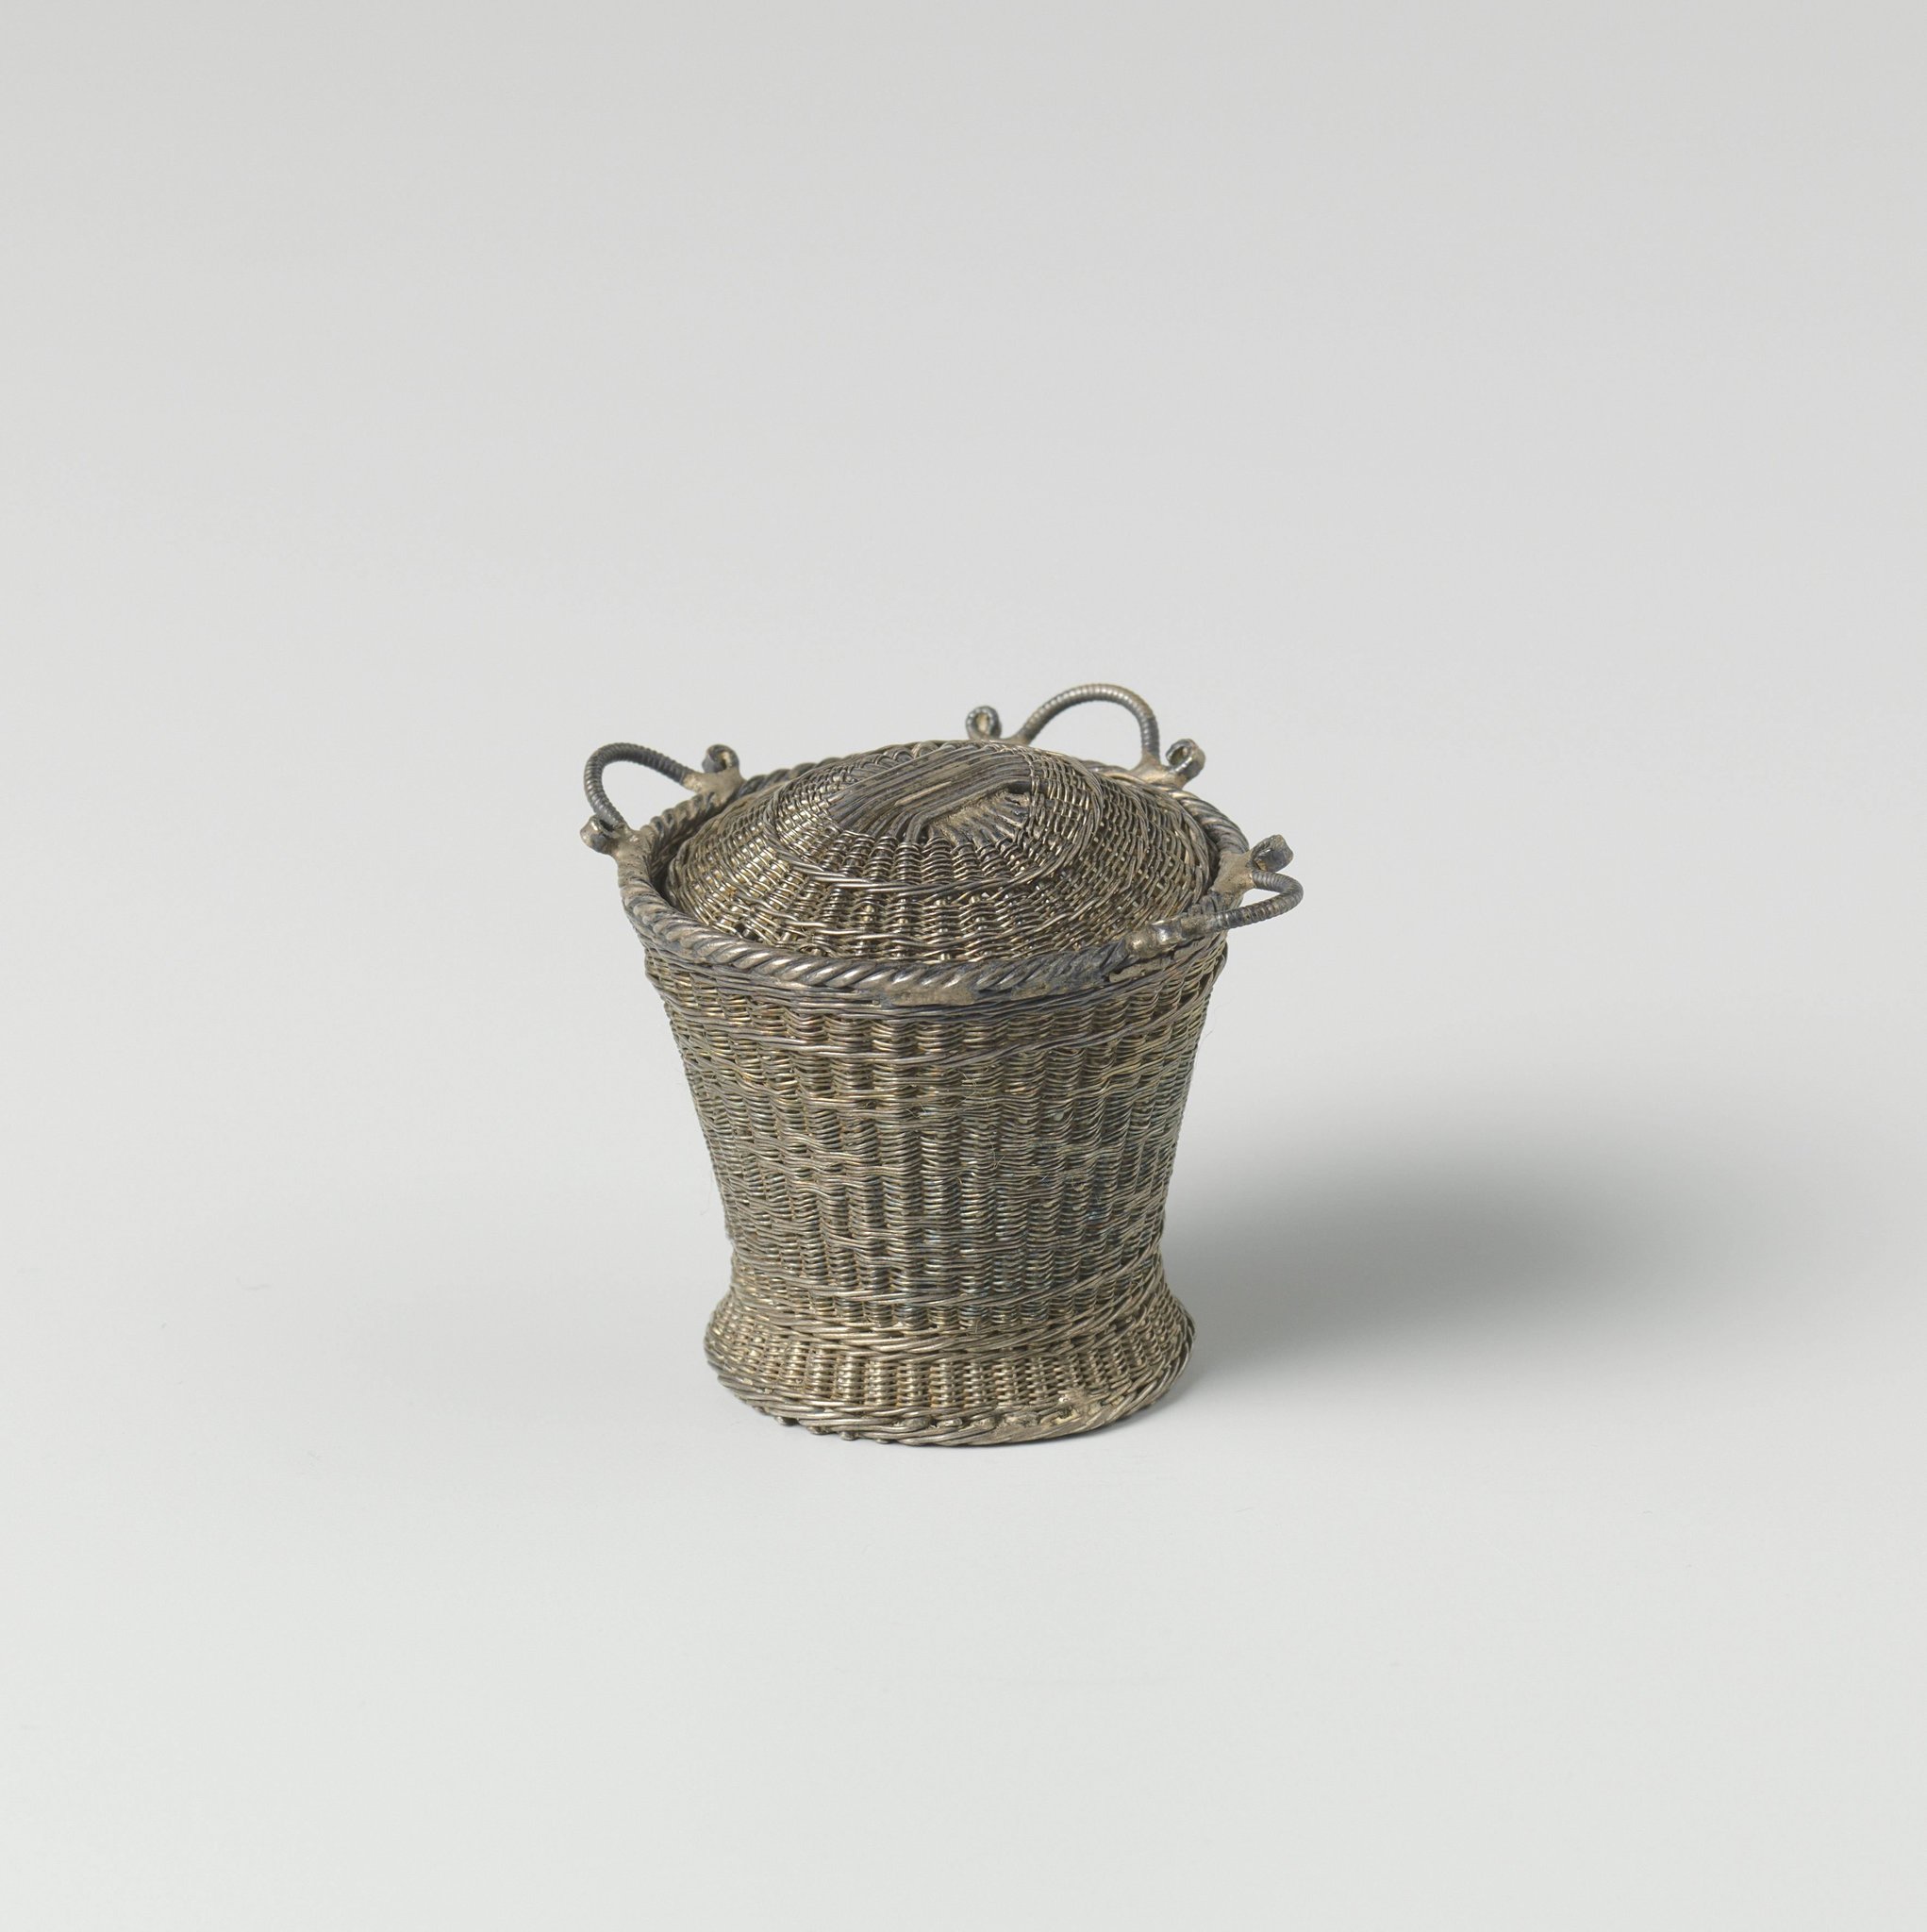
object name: miniature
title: Mand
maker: Anonymous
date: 1700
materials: silver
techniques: filigree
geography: netherlands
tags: container made of plant material other than wood: basket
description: Ronde mand van gevlochten zilverdraad. De mand heeft een massieve bodem en staat op een voet. De mand heeft drie handvatten en een deksel. De mand is niet gemerkt.